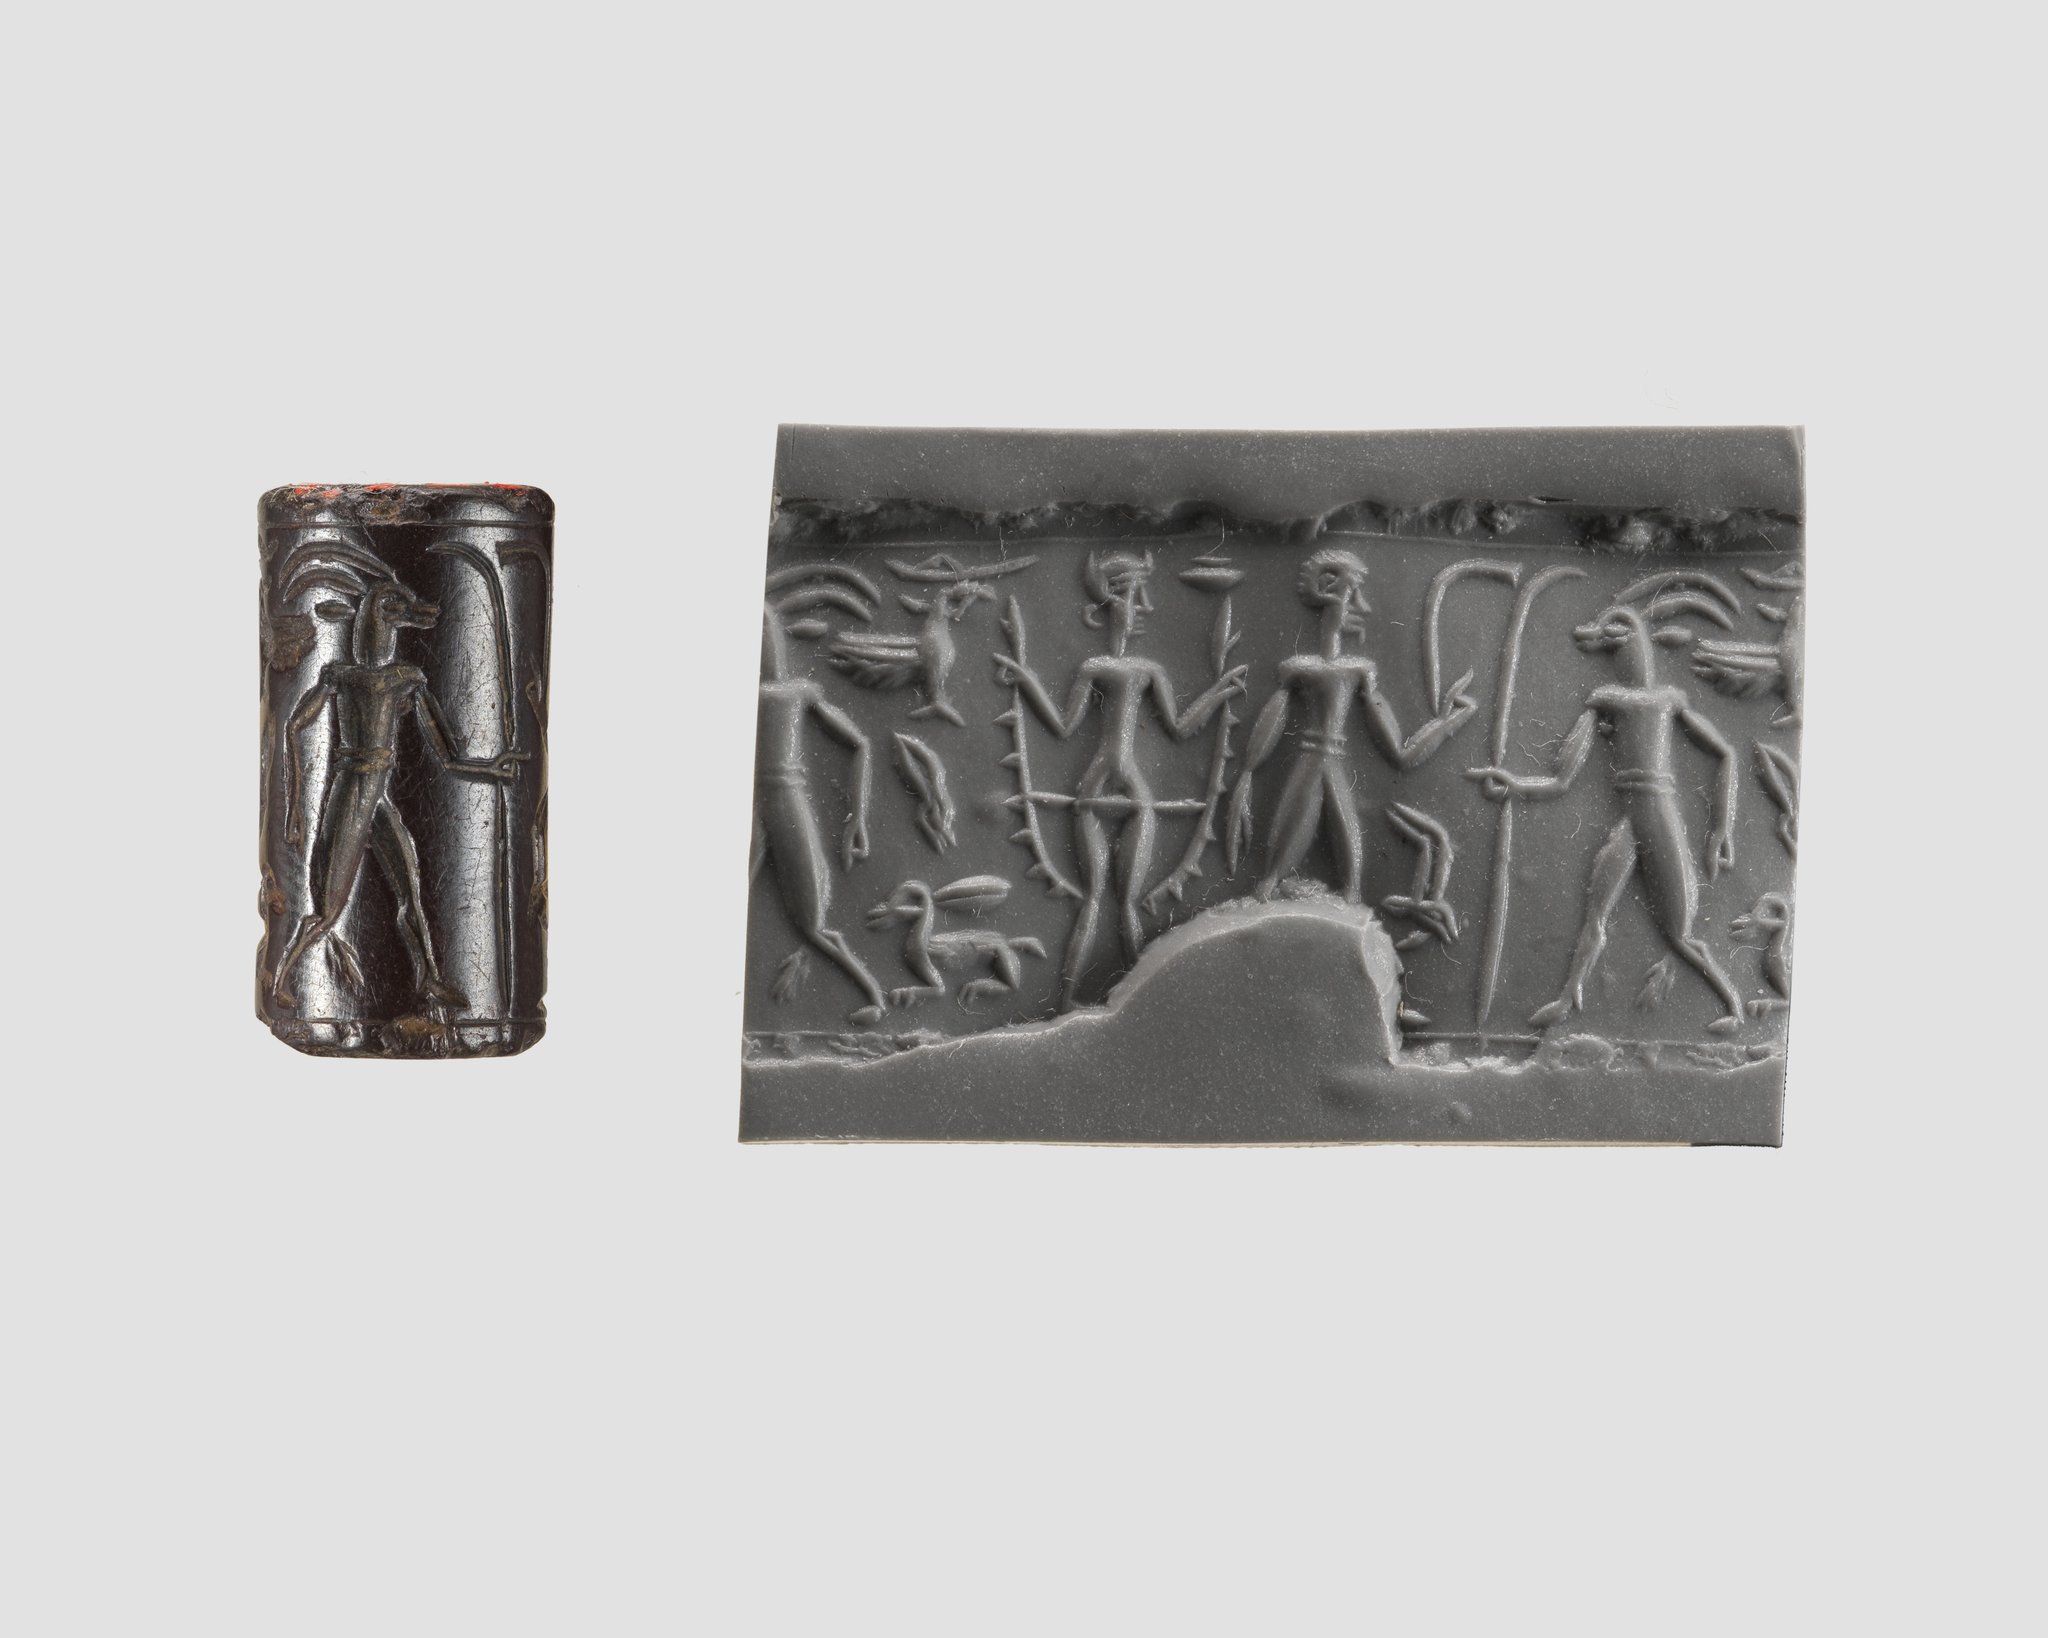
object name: cylinder seal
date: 1820-1730 BCE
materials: mineral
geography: syria